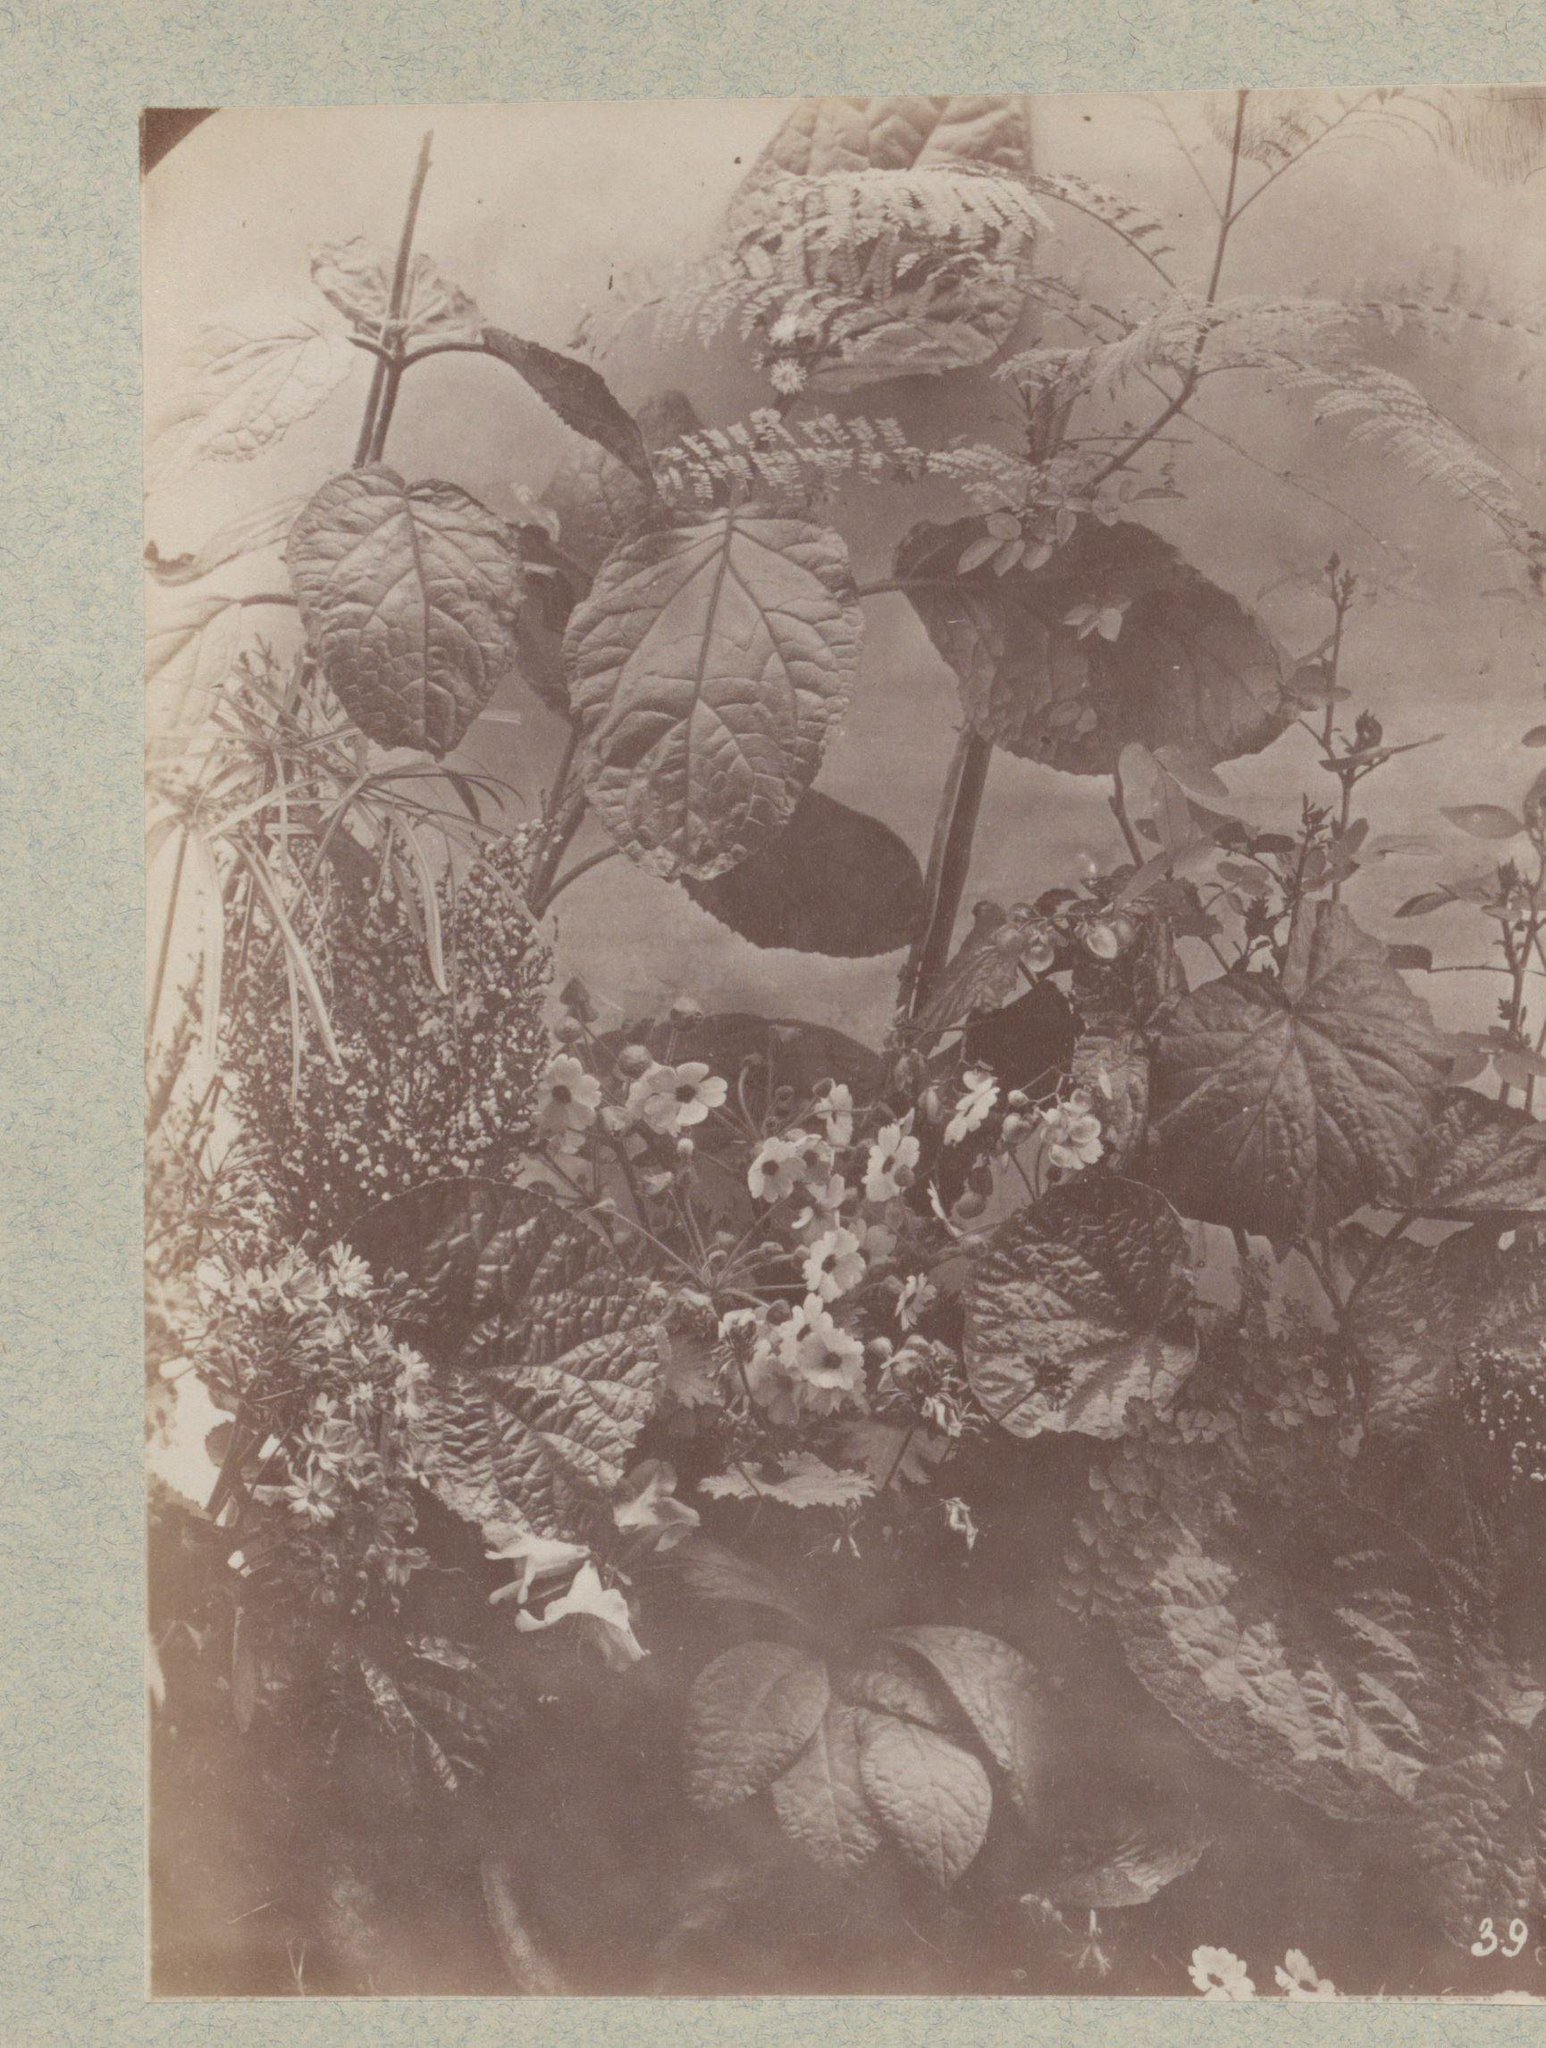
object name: photograph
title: Bloemstudie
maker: a. calavas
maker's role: publisher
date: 1875-1895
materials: cardboard, photographic support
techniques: albumen print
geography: paris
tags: flowers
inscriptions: number: ‘39’, collector's mark: Lugt 3937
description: Onderdeel van Verzamelband met foto's van bloemstudies.